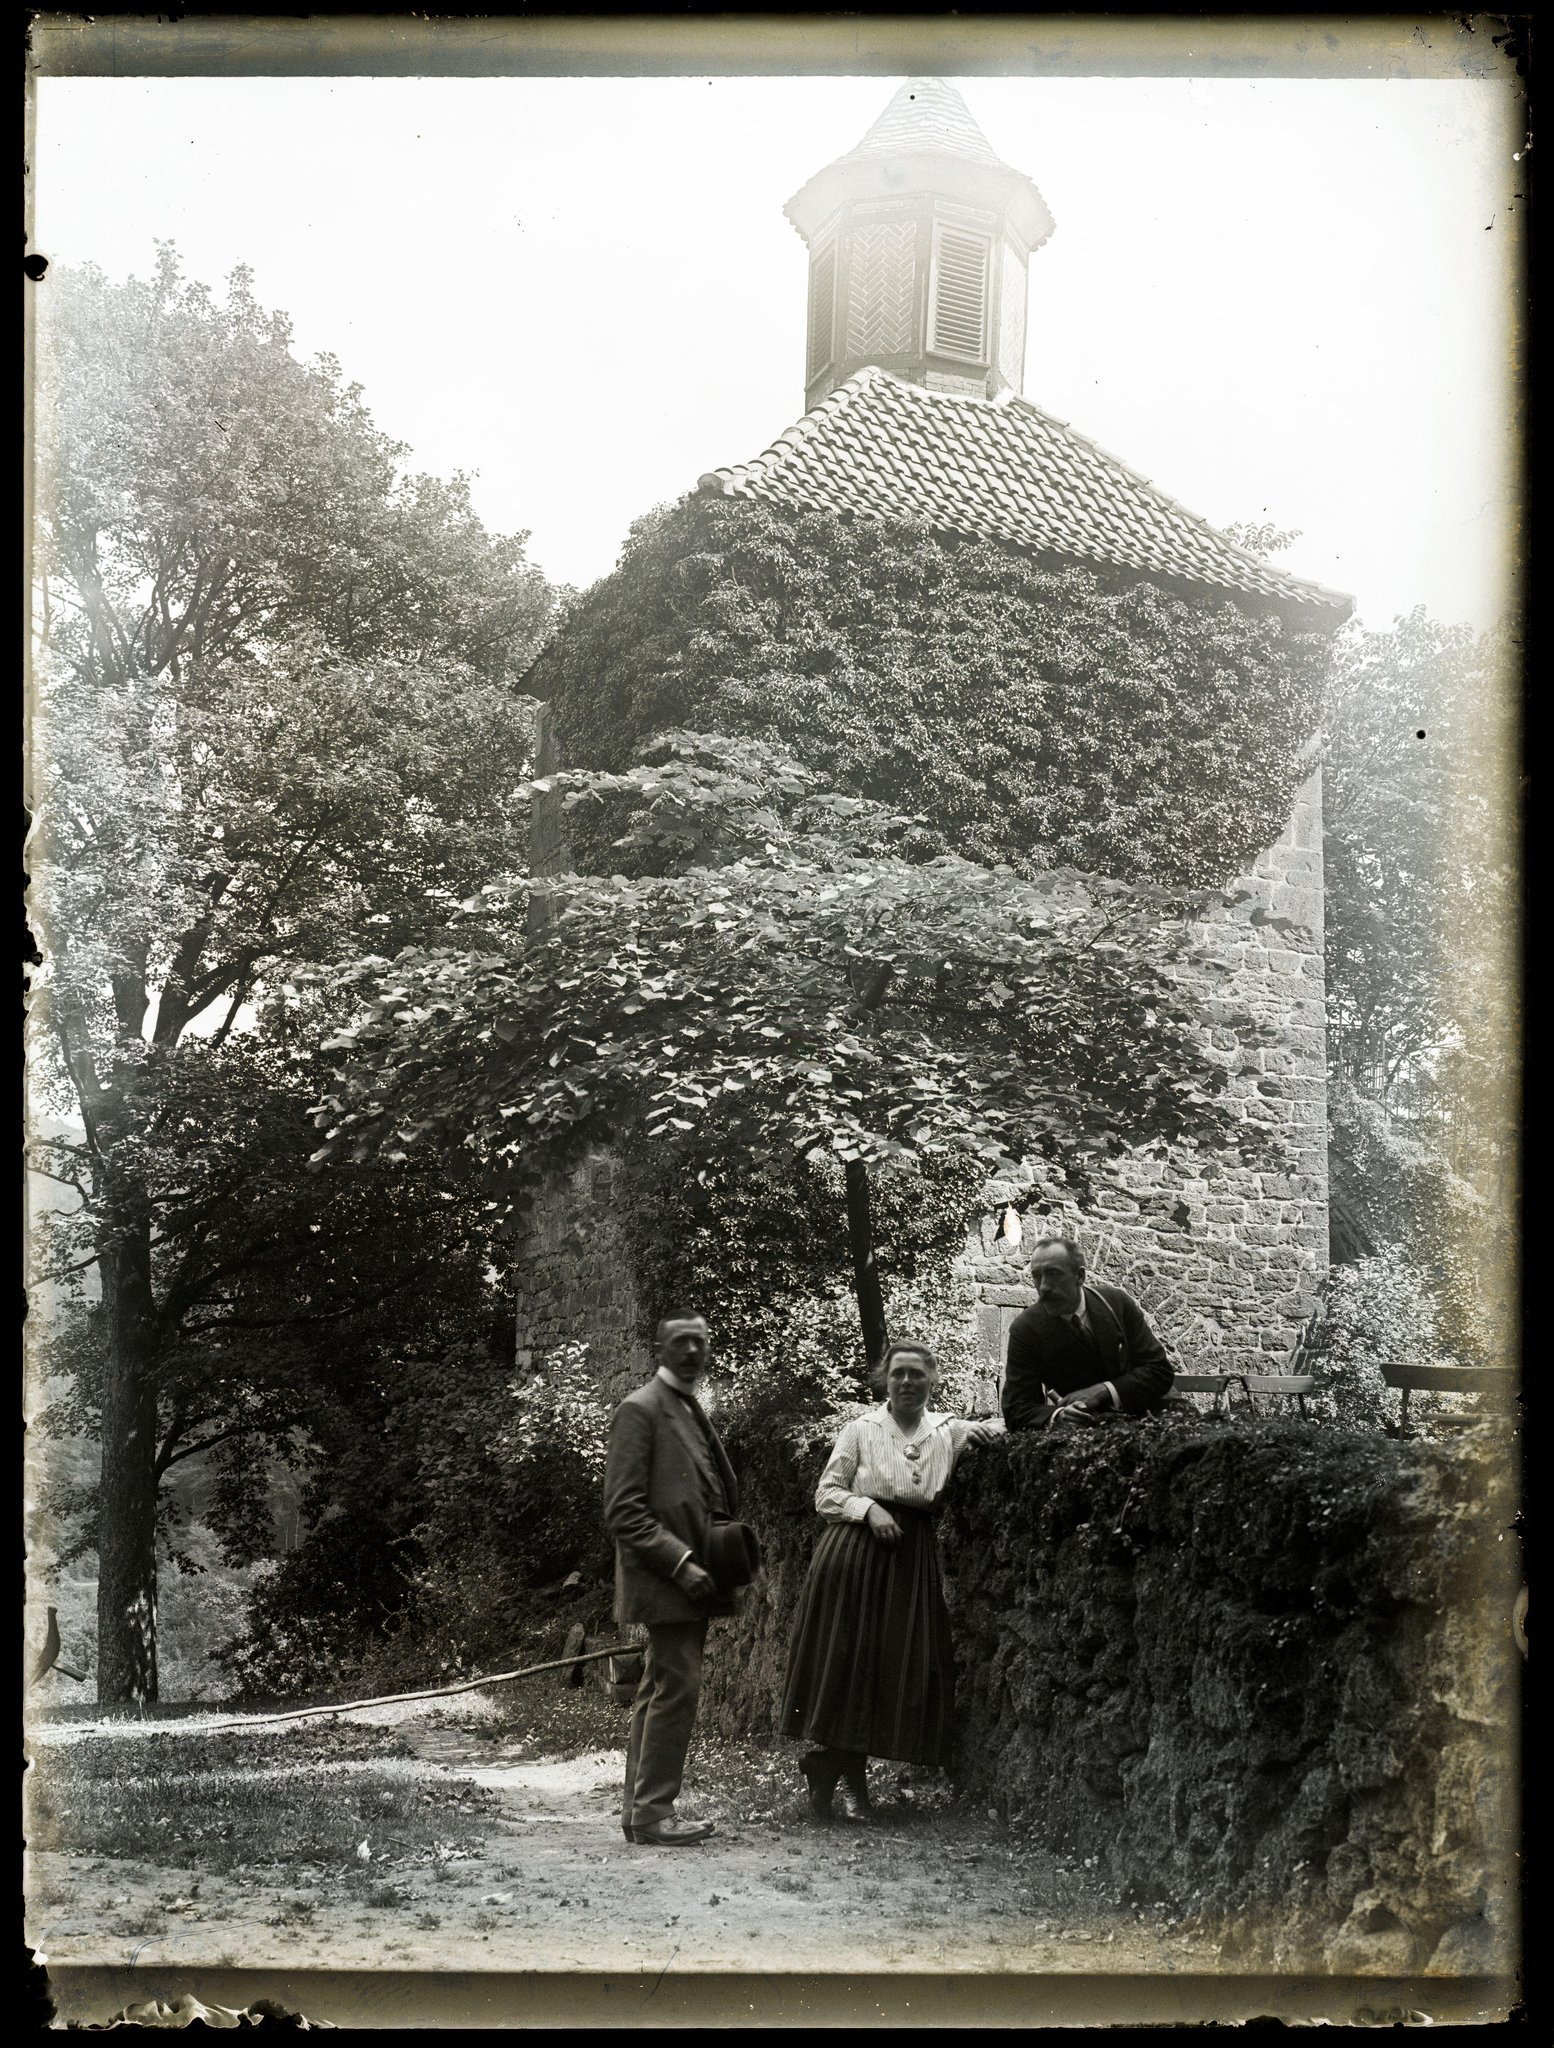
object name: glasnegatief, glasplaatnegatief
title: Vrouw en twee mannen bij een toren in een tuin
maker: Anonymous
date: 1907-1935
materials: glass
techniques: gelatin glass negative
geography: europe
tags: landscape with tower or castle, historical persons not known by name, europe